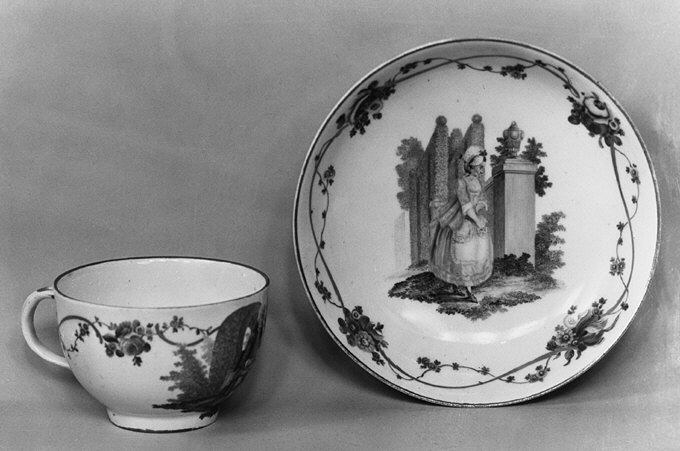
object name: cup and saucer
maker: ludwigsburg porcelain manufactory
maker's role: manufactory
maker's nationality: german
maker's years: 1758-1824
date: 1770-1780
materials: hard paste porcelain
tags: buildings,women,flowers